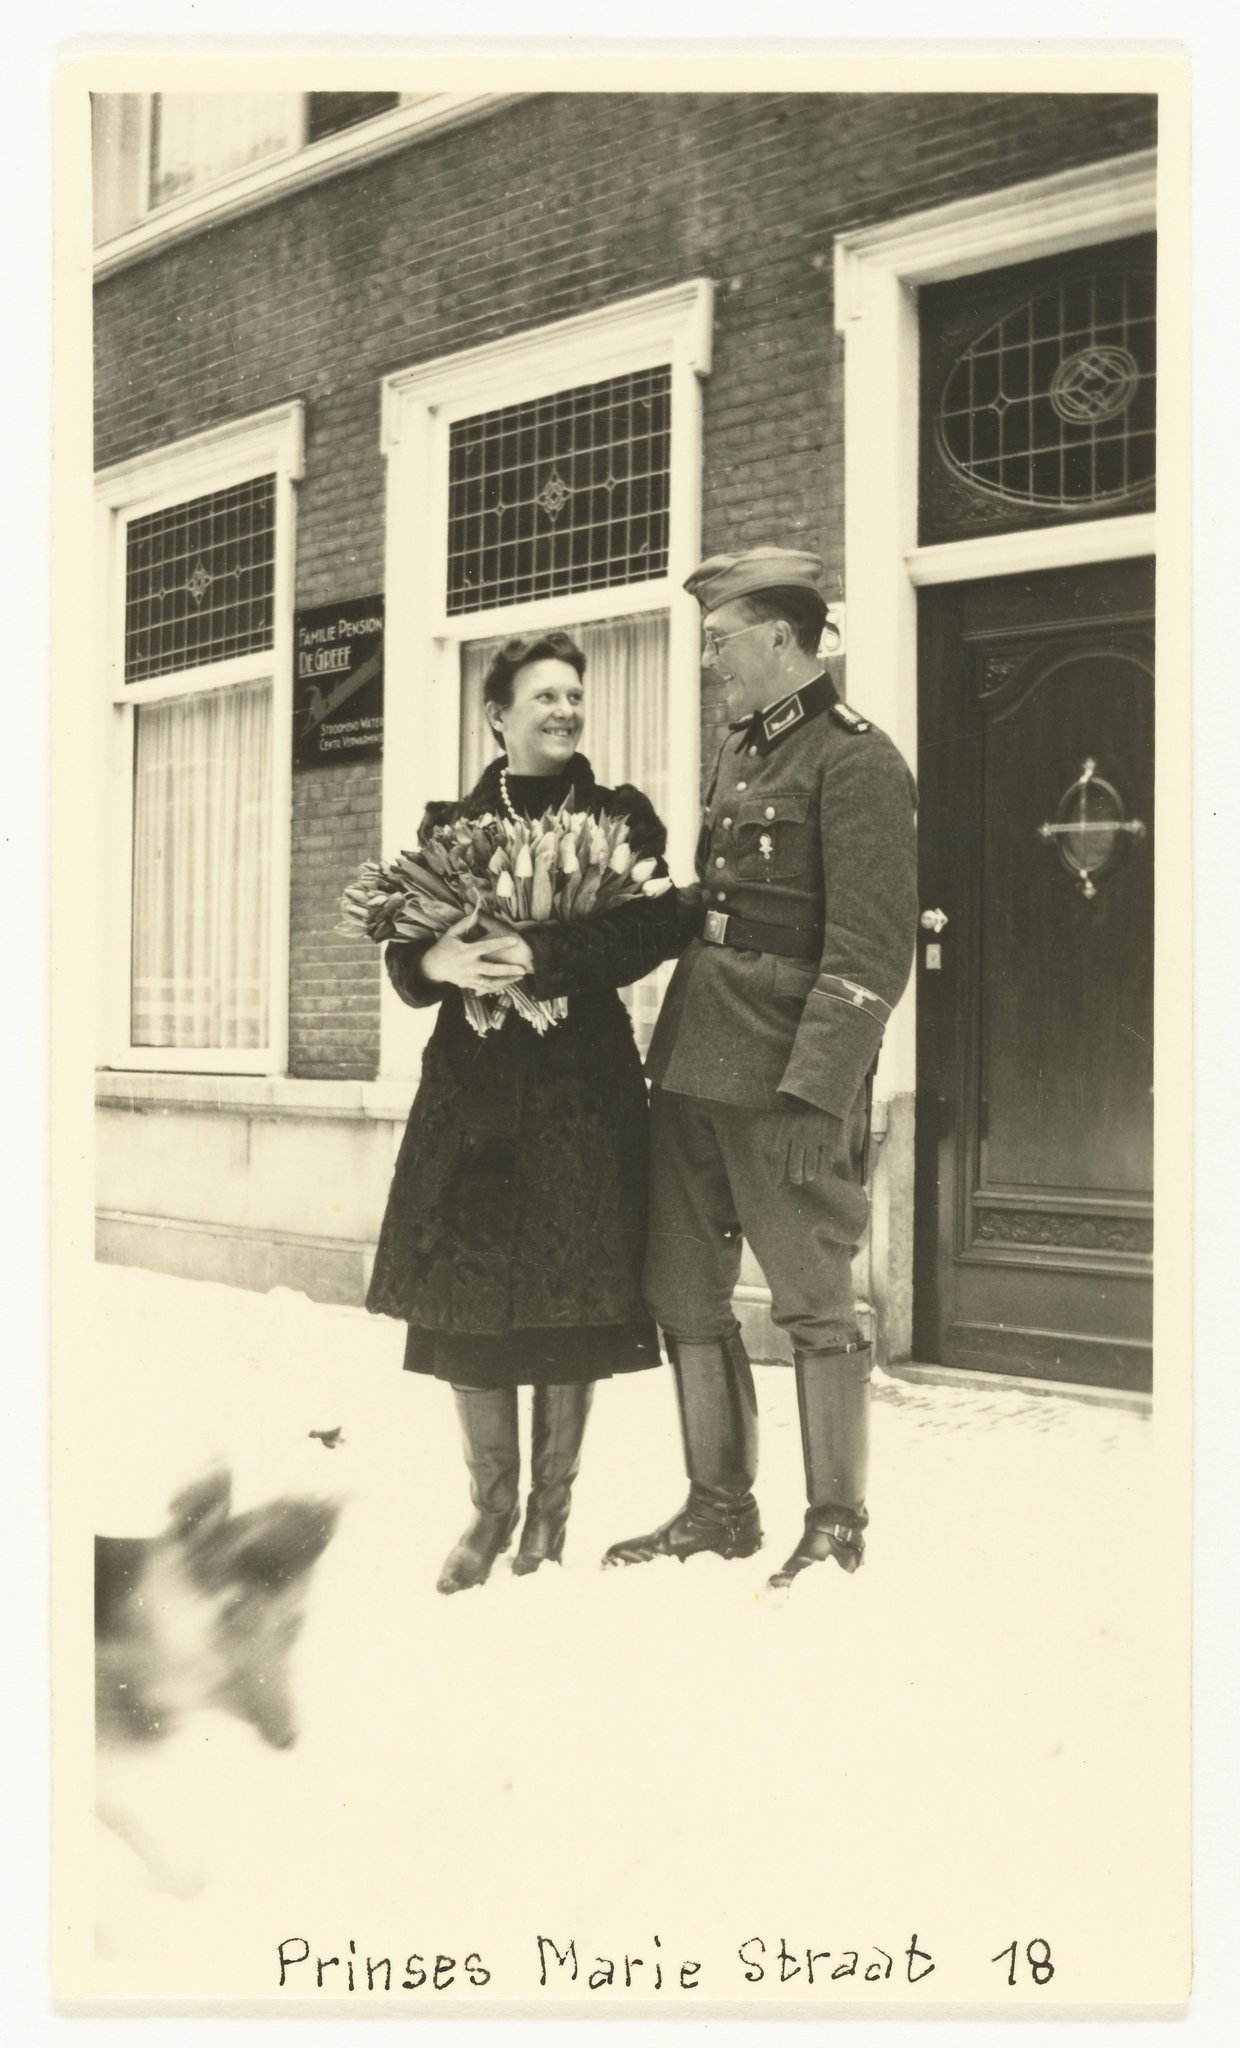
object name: photograph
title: Duitse soldaat met Nederlandse vrouw in de sneeuw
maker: Anonymous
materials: photographic support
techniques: gelatin silver print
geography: the hague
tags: occupier and civilians, occupation ~ war, the hague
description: Een Duitse soldaat staat lachend naast een Nederlandse vrouw in de sneeuw. Zij houdt een grote bos tulpen in haar armen en lacht naar hem. Achter hen huizen met glas in lood ramen en links een bord van een firma. Een pension? Links de kop van een hond. Onderaan de foto staat Prinses Mariestraat 18. (Zelfde man als NG-2007-5-35 t/m 45).